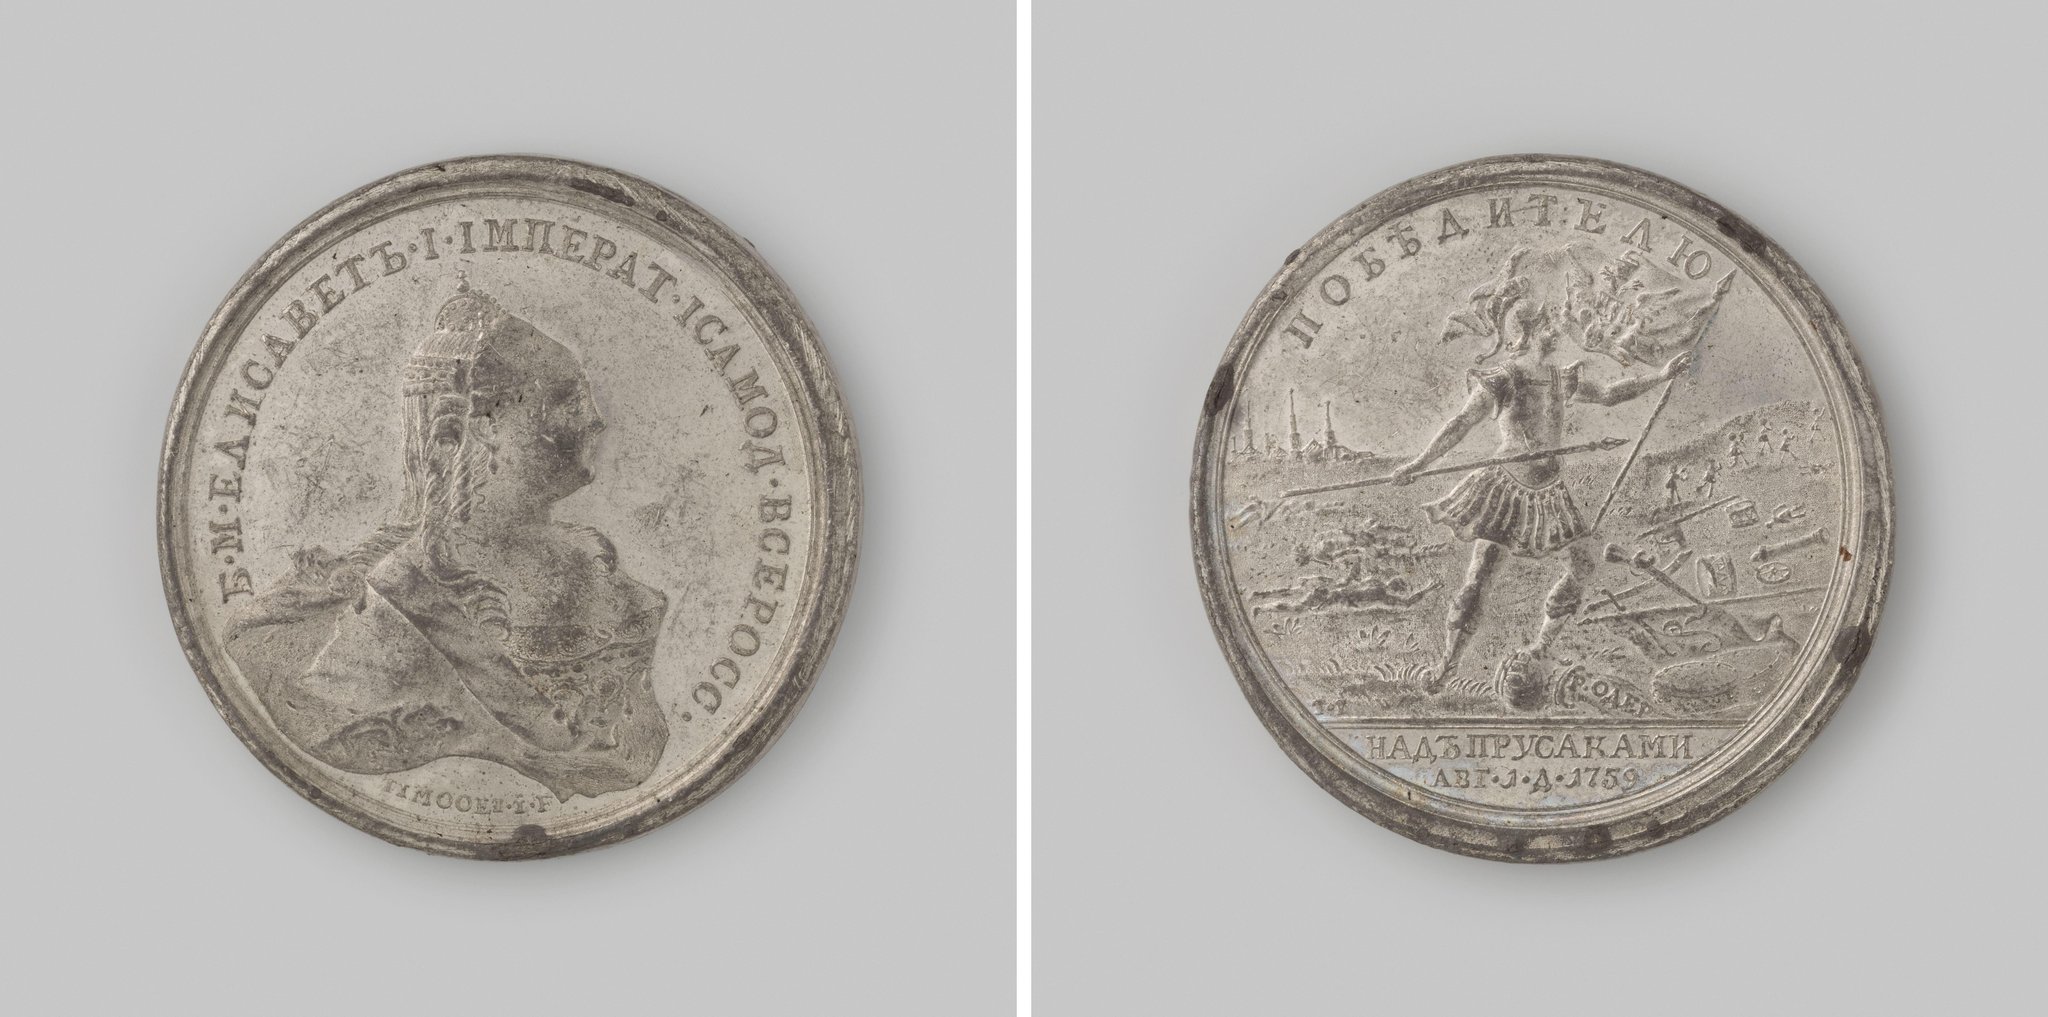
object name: history medal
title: Overwinning van Rusland op Pruisen in de veldslagen van Crossen en Frankfurt aan de Oder / (Kunersdorf 1759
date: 1759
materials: tin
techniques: striking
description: Tinnen penning, op de voorzijde het borstbeeld van Tsarina Elisabeth naar rechts met omschrift, op de keerzijde een soldaat met speer en vaandel, de voet op een uitstromende urn, op een slagveld met vluchtende vijanden, met omschrift en afsnedetekst.